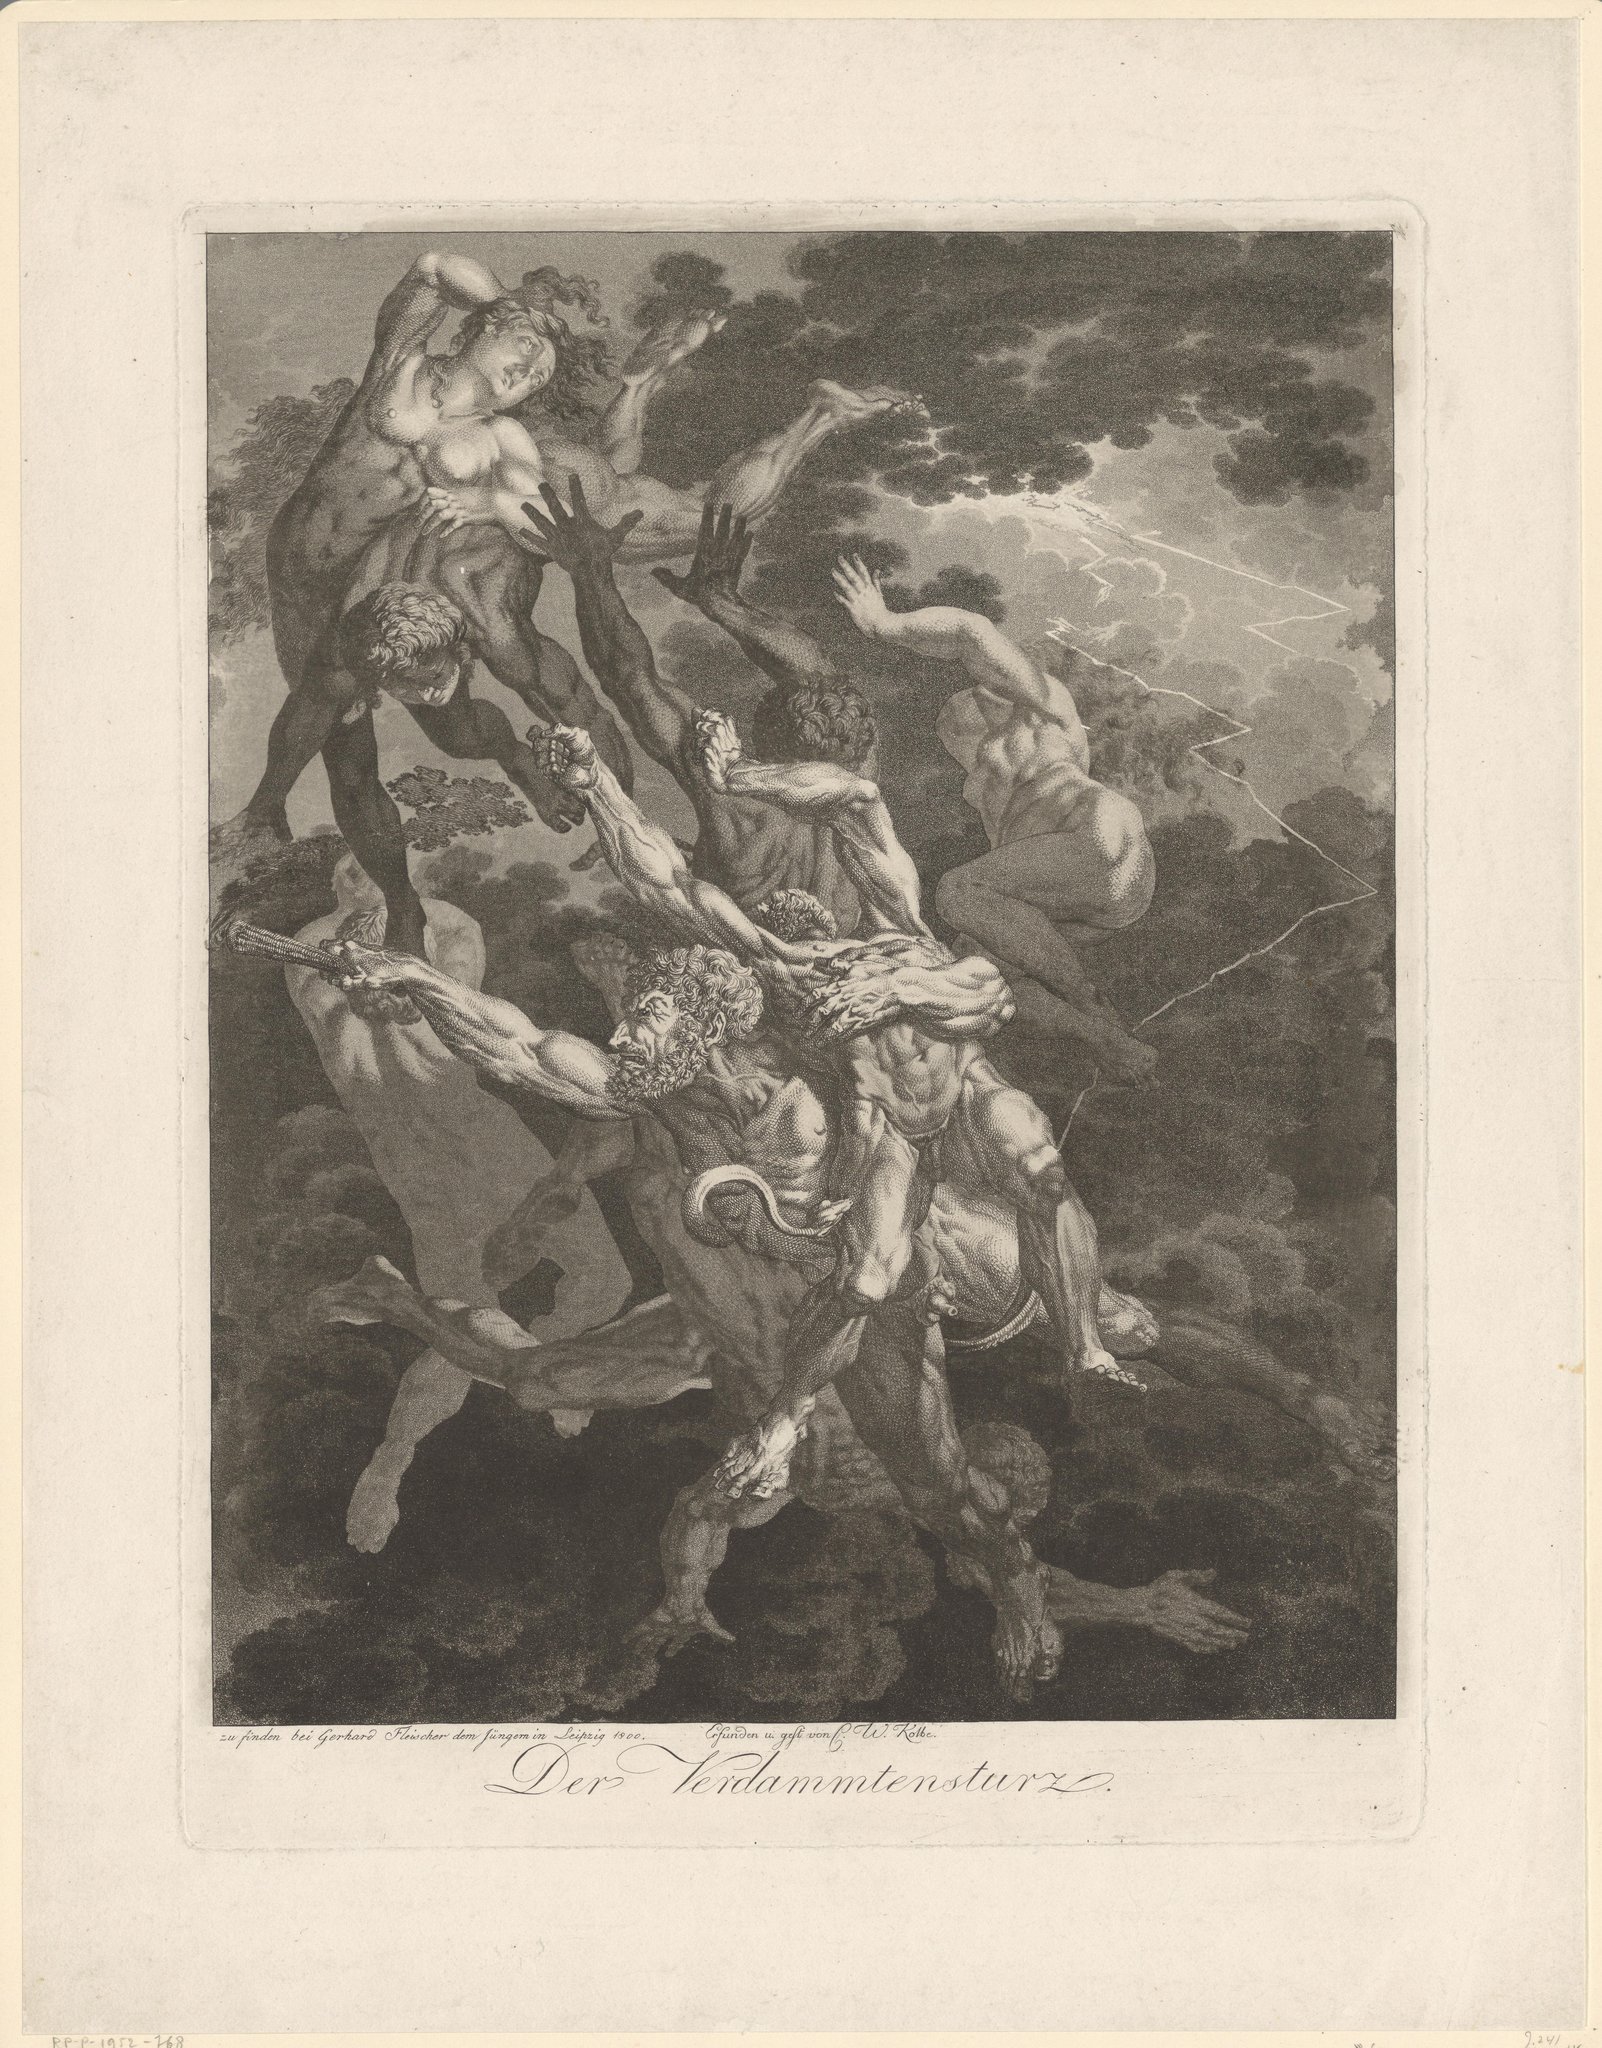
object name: print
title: Zeven mensen vallen in de armen van de duivel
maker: carl wilhelm kolbe (i)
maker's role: print maker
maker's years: 1757-1835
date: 1767-1801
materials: paper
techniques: etching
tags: falling through the air, fate, doom, human-shaped devils ~ musculous hades type, lightning, flash of lightning, thunderbolt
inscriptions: collector's mark: Lugt 2228